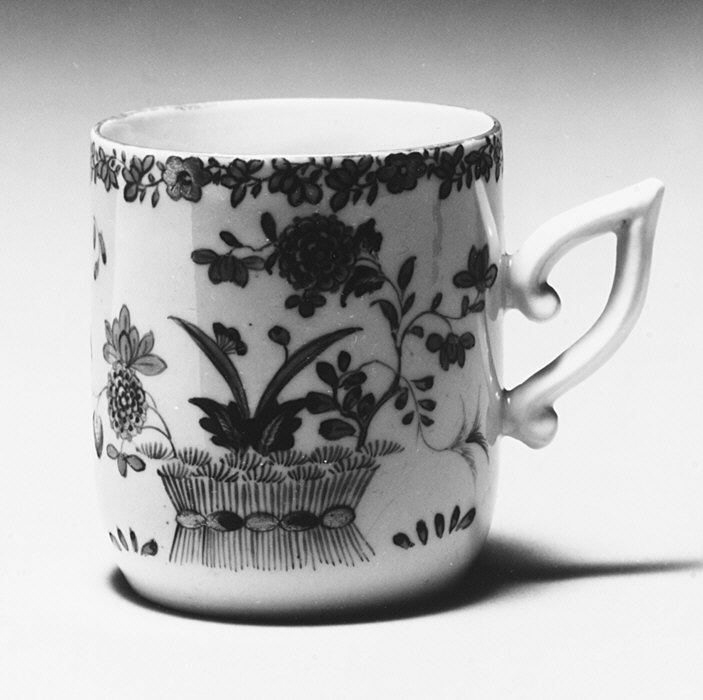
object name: cup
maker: derby porcelain manufactory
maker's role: factory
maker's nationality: british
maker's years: 1751-1785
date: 1755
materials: soft paste porcelain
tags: flowers